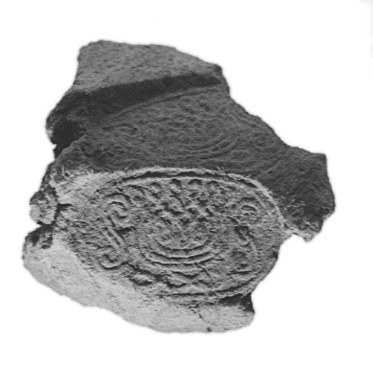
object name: sealing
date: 2030-1640 BCE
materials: clay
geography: egypt